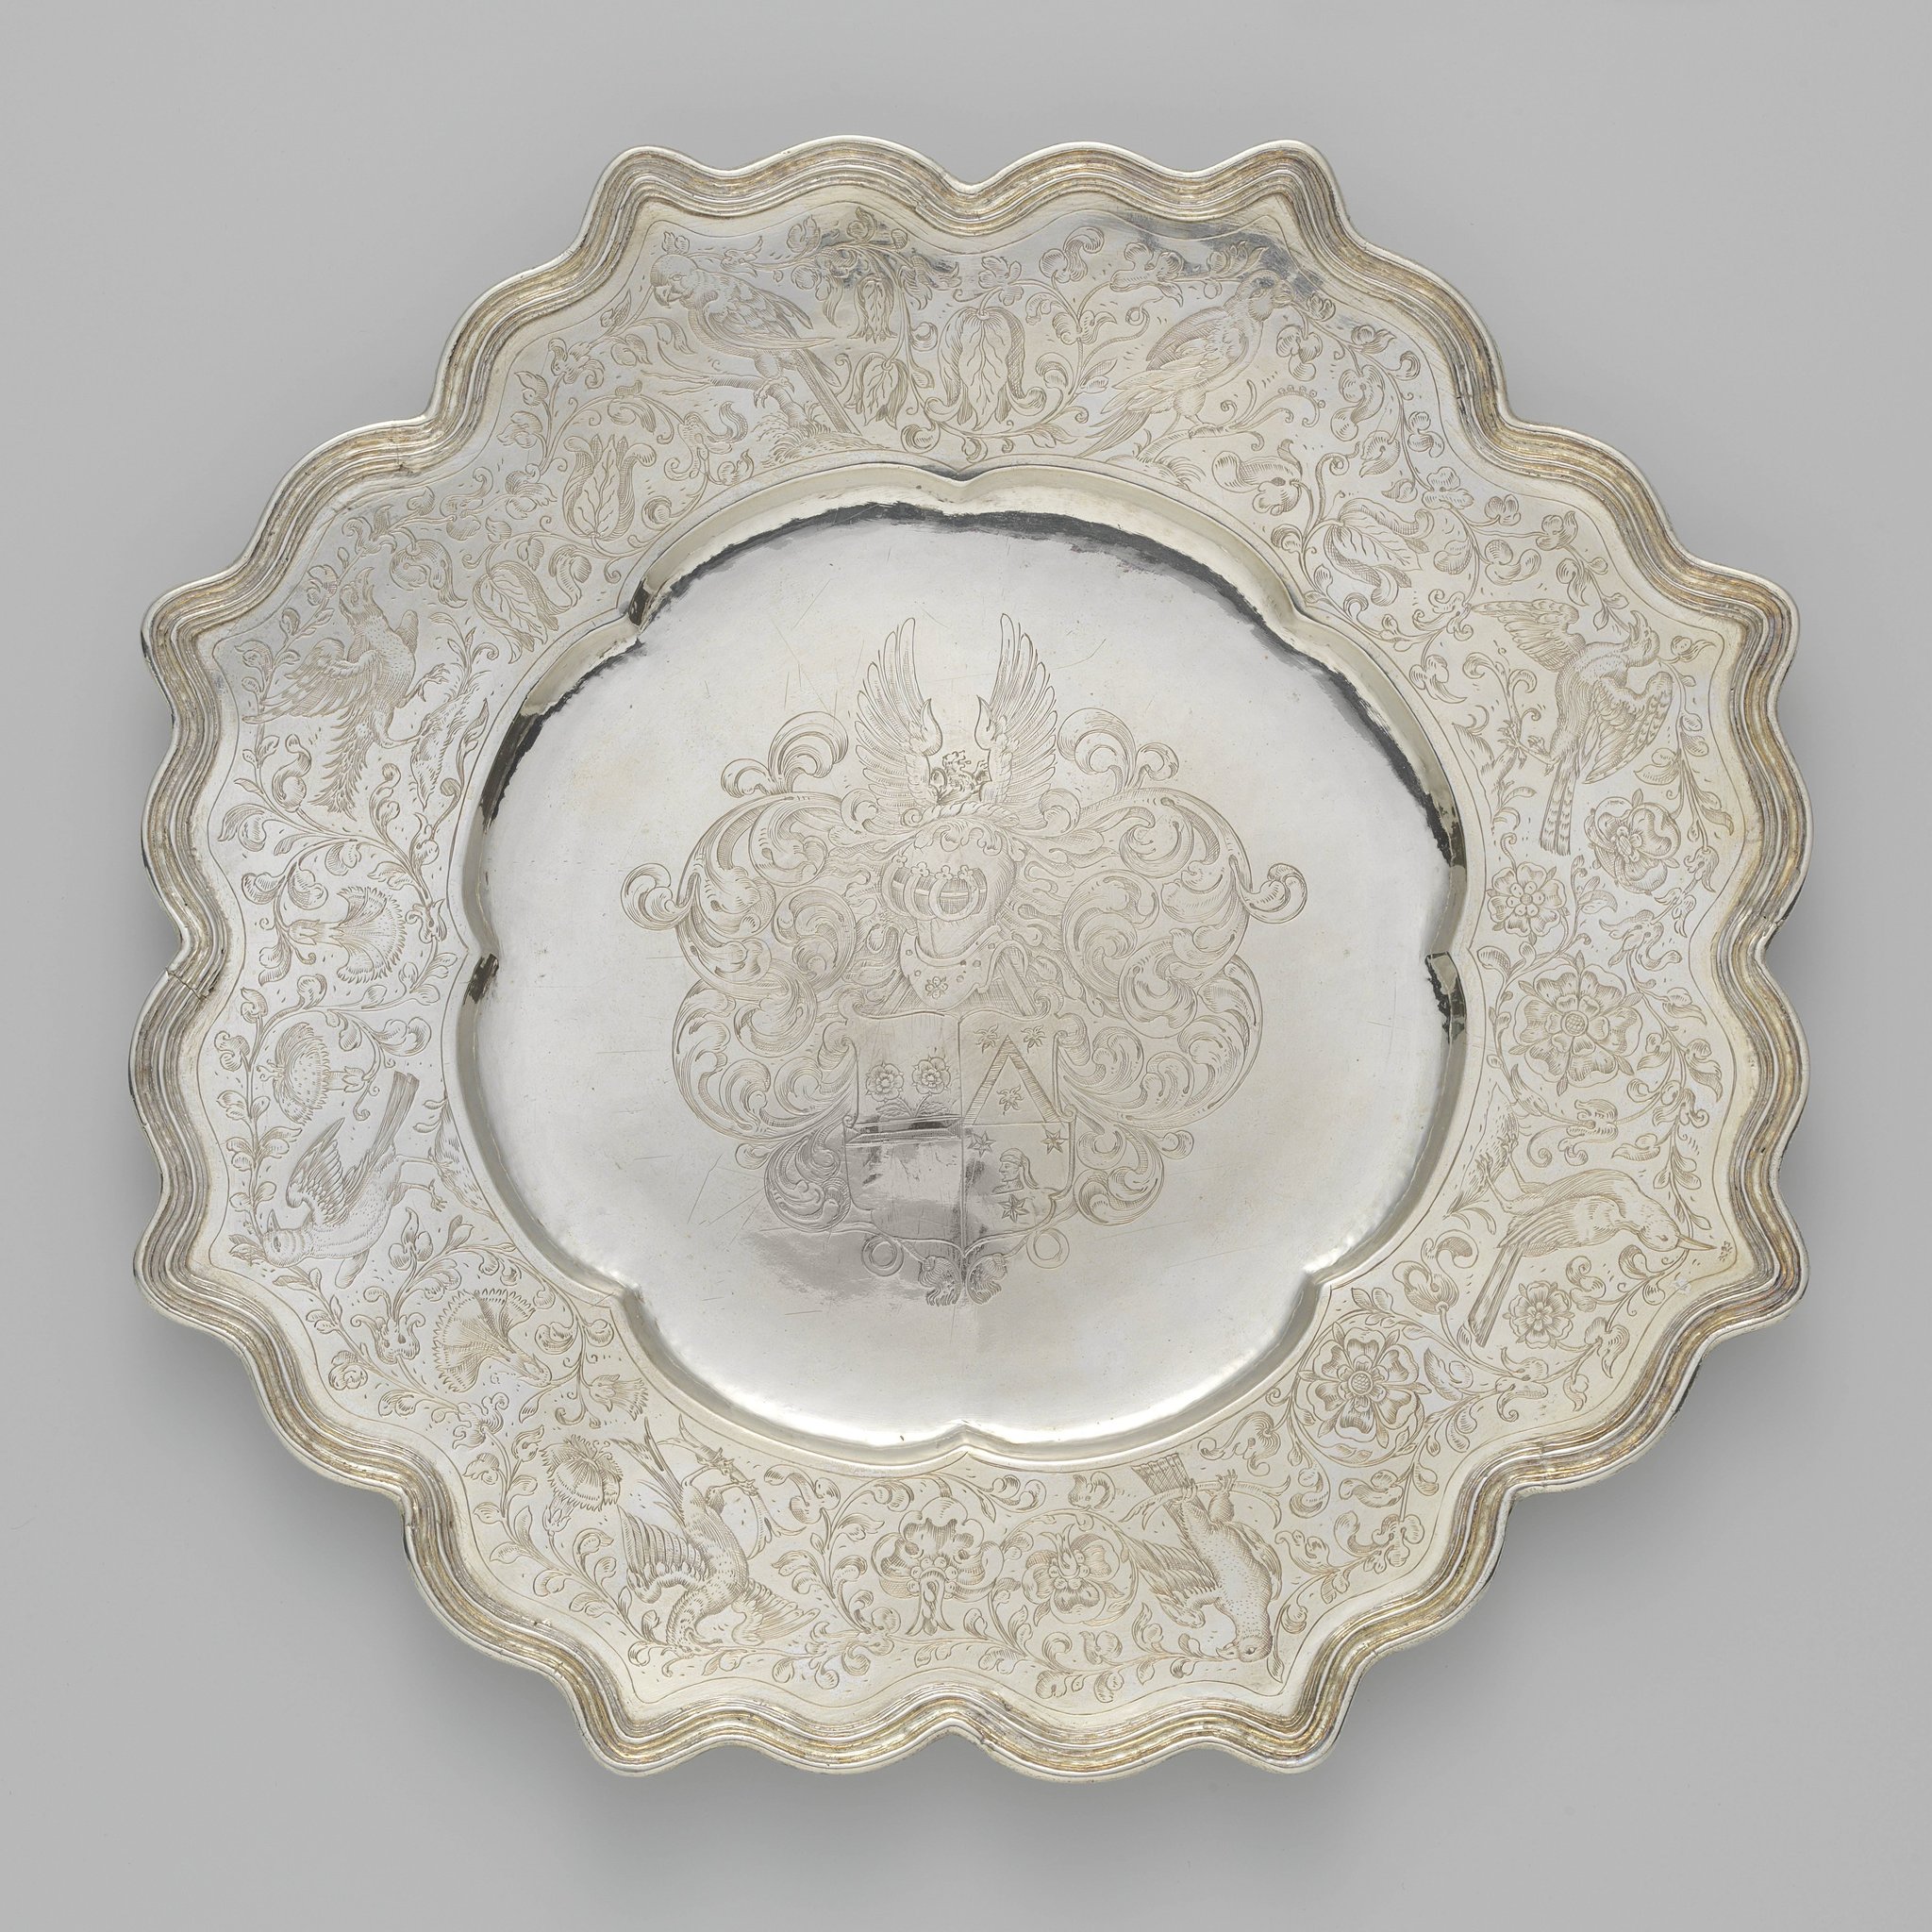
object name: dish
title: Schaal met de wapens van Caspar Hendrik Schickhart en Judith ter Welberg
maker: claes hansen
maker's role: silversmith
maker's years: 1619-1675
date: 1646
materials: silver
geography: zwolle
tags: flowers ~ ornament, armorial bearing, heraldry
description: Salver with the arms of Capar Hendrik Schickhart, sheriff of Meppel, and his wife Judith ter Welbergh. Silver. Zwolle, 1646, by Claes Hansen.